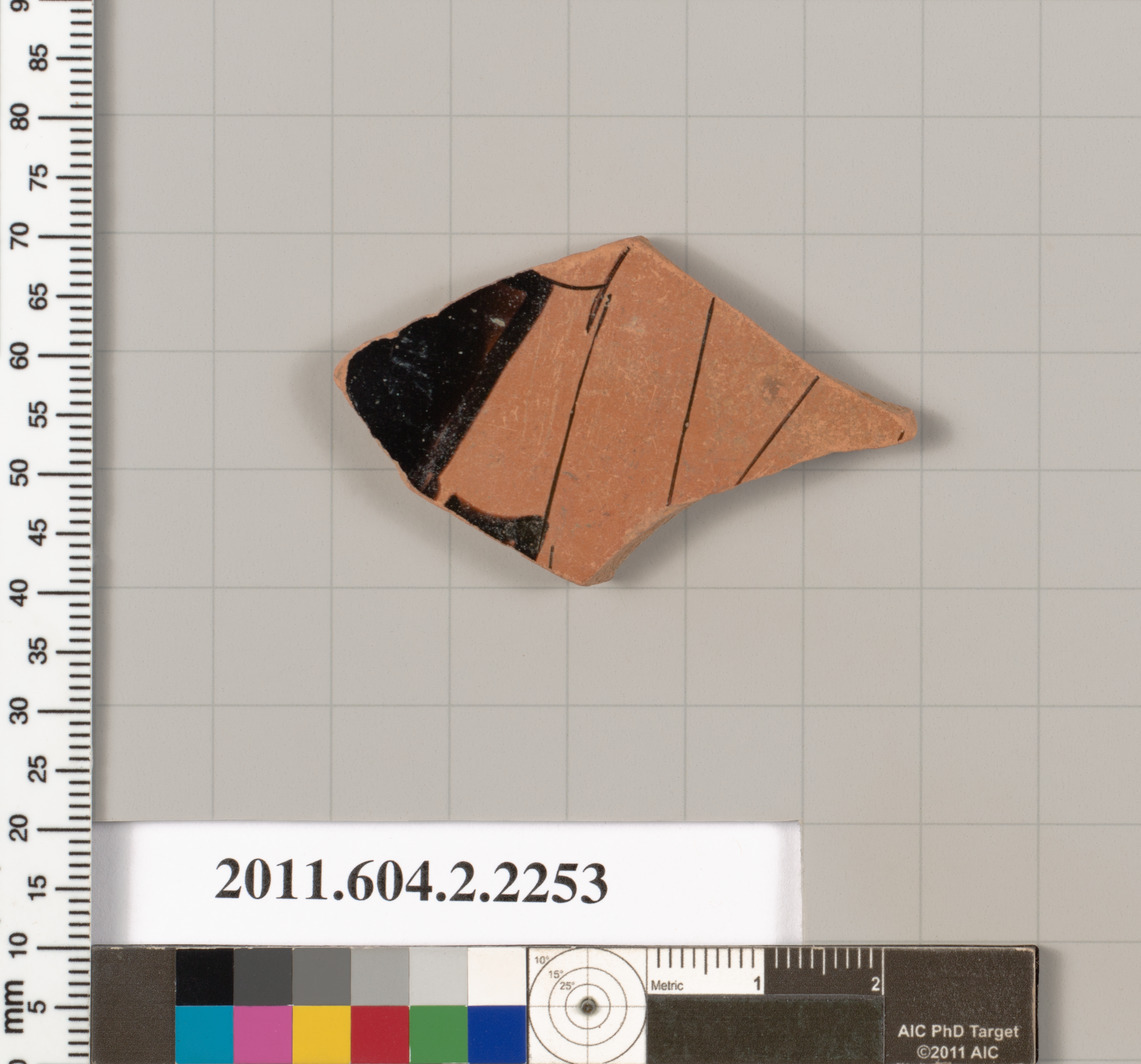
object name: pot fragment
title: Terracotta fragment of a pot; unglazed on the inside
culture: greek, attic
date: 475-451 BCE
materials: terracotta